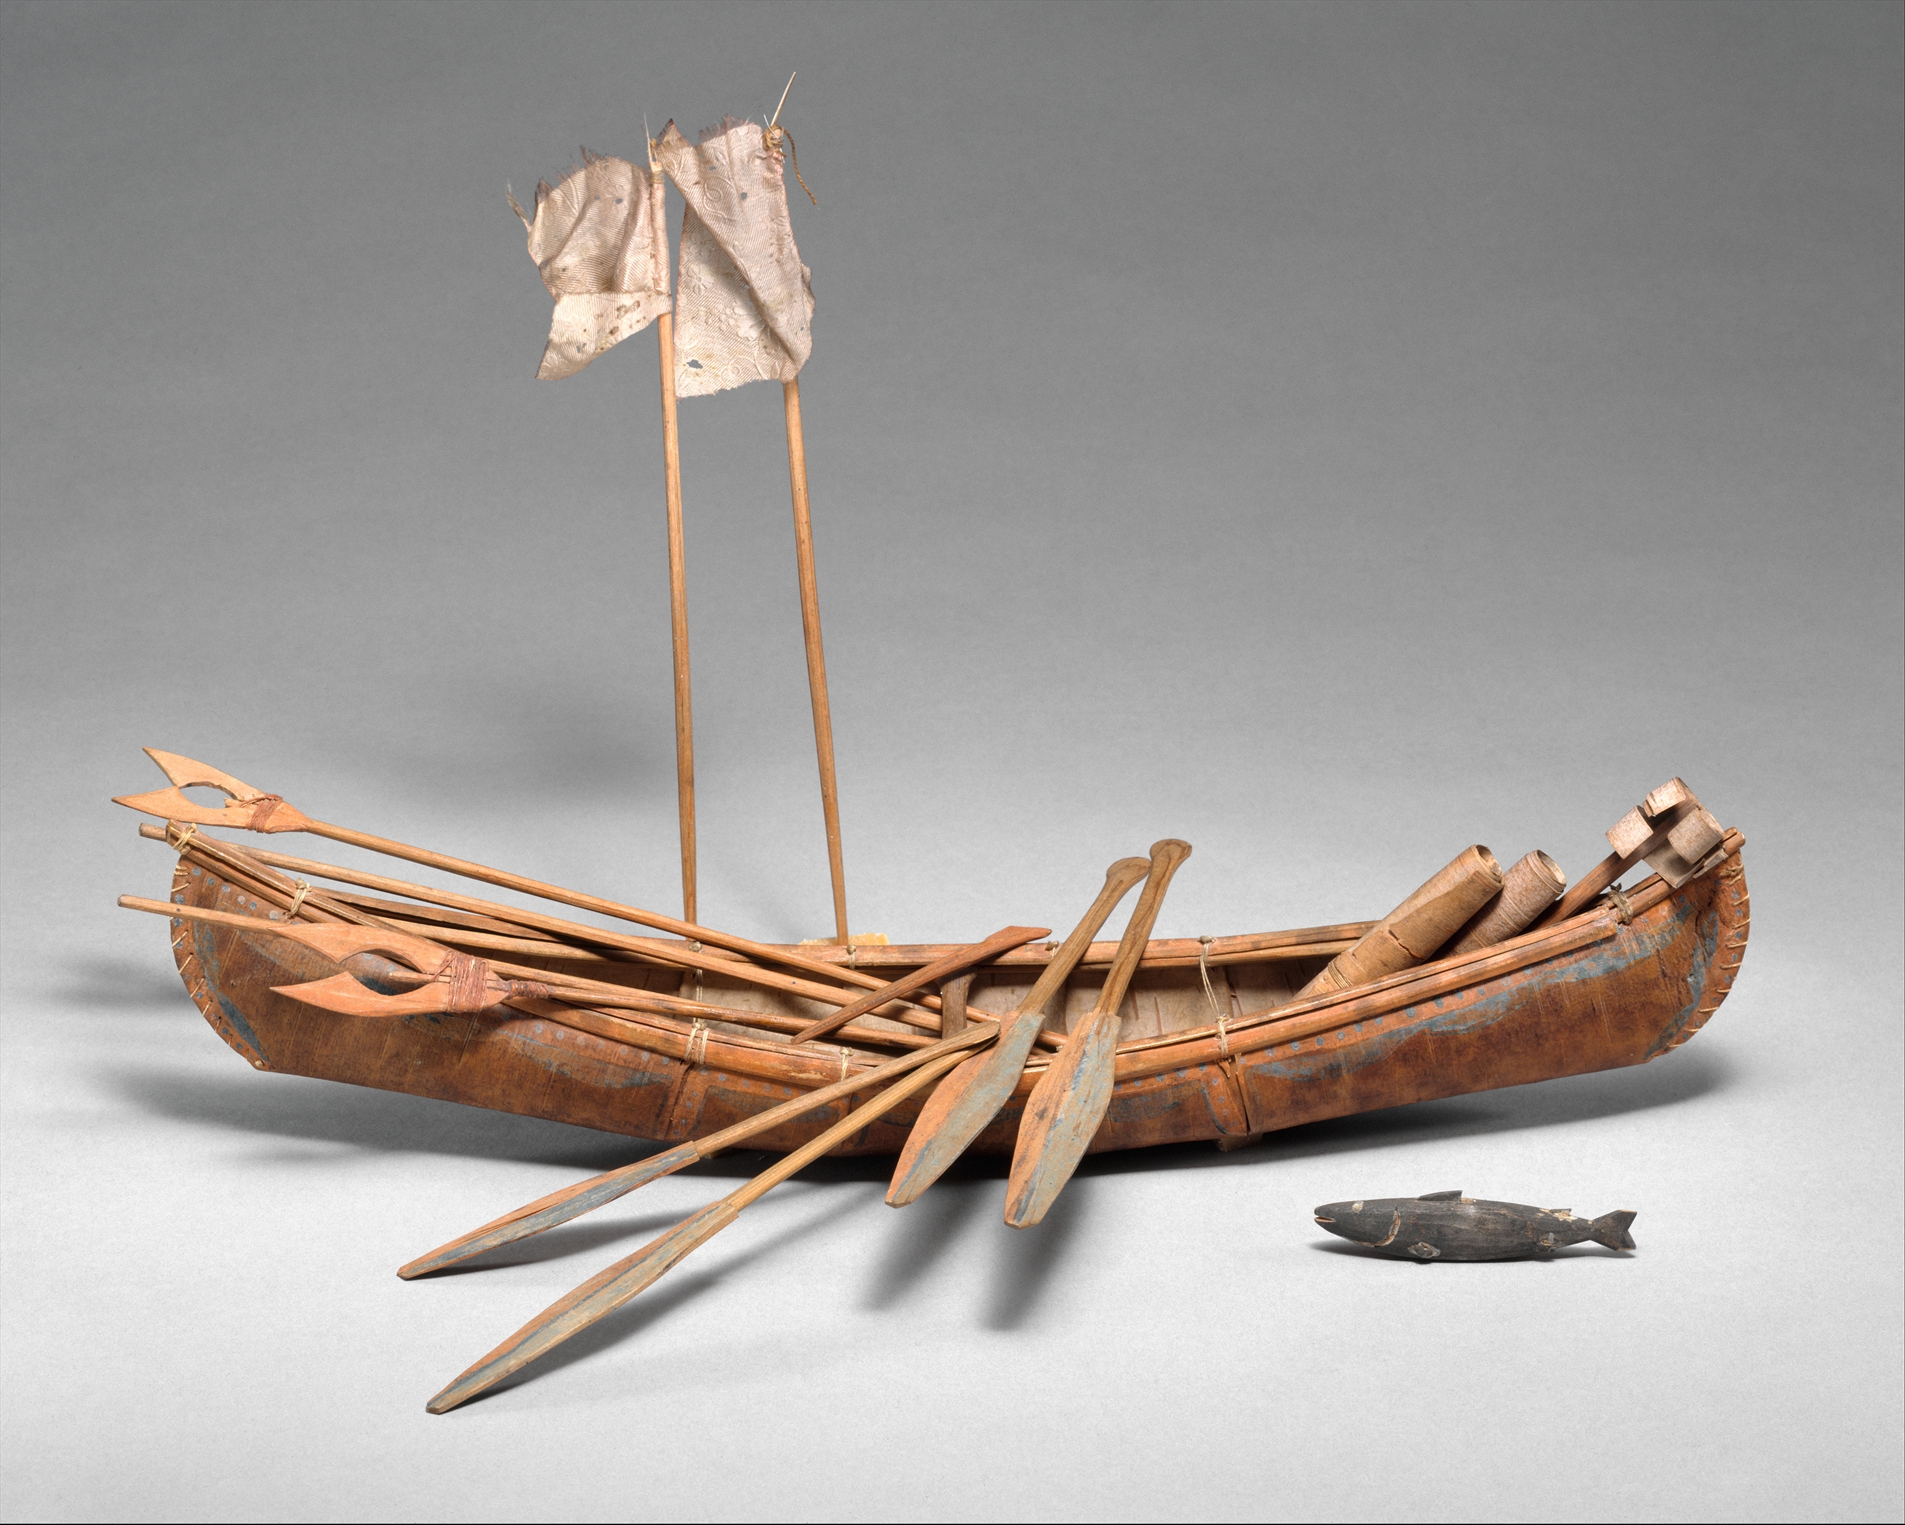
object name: canoe model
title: Canoe Model with Accoutrements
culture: maliseet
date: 1845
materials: fiber, silk, wood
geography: canada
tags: boats